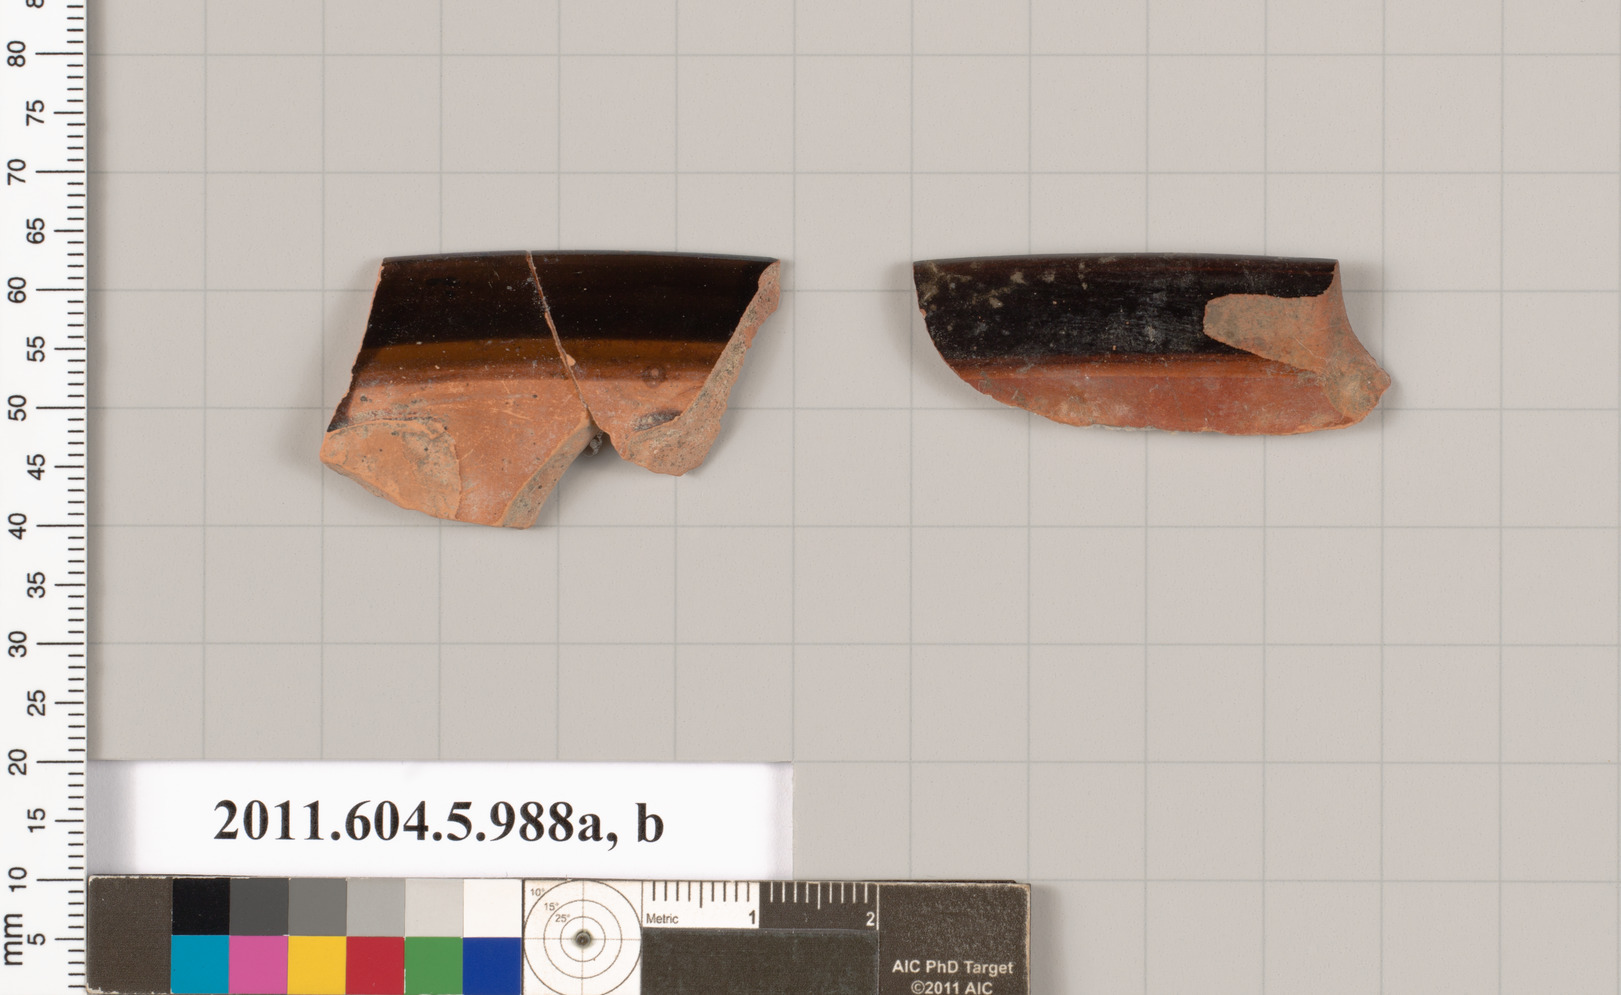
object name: kylix fragment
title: Terracotta rim fragments of kylikes (drinking cups)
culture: greek, attic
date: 600-401 BCE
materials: terracotta